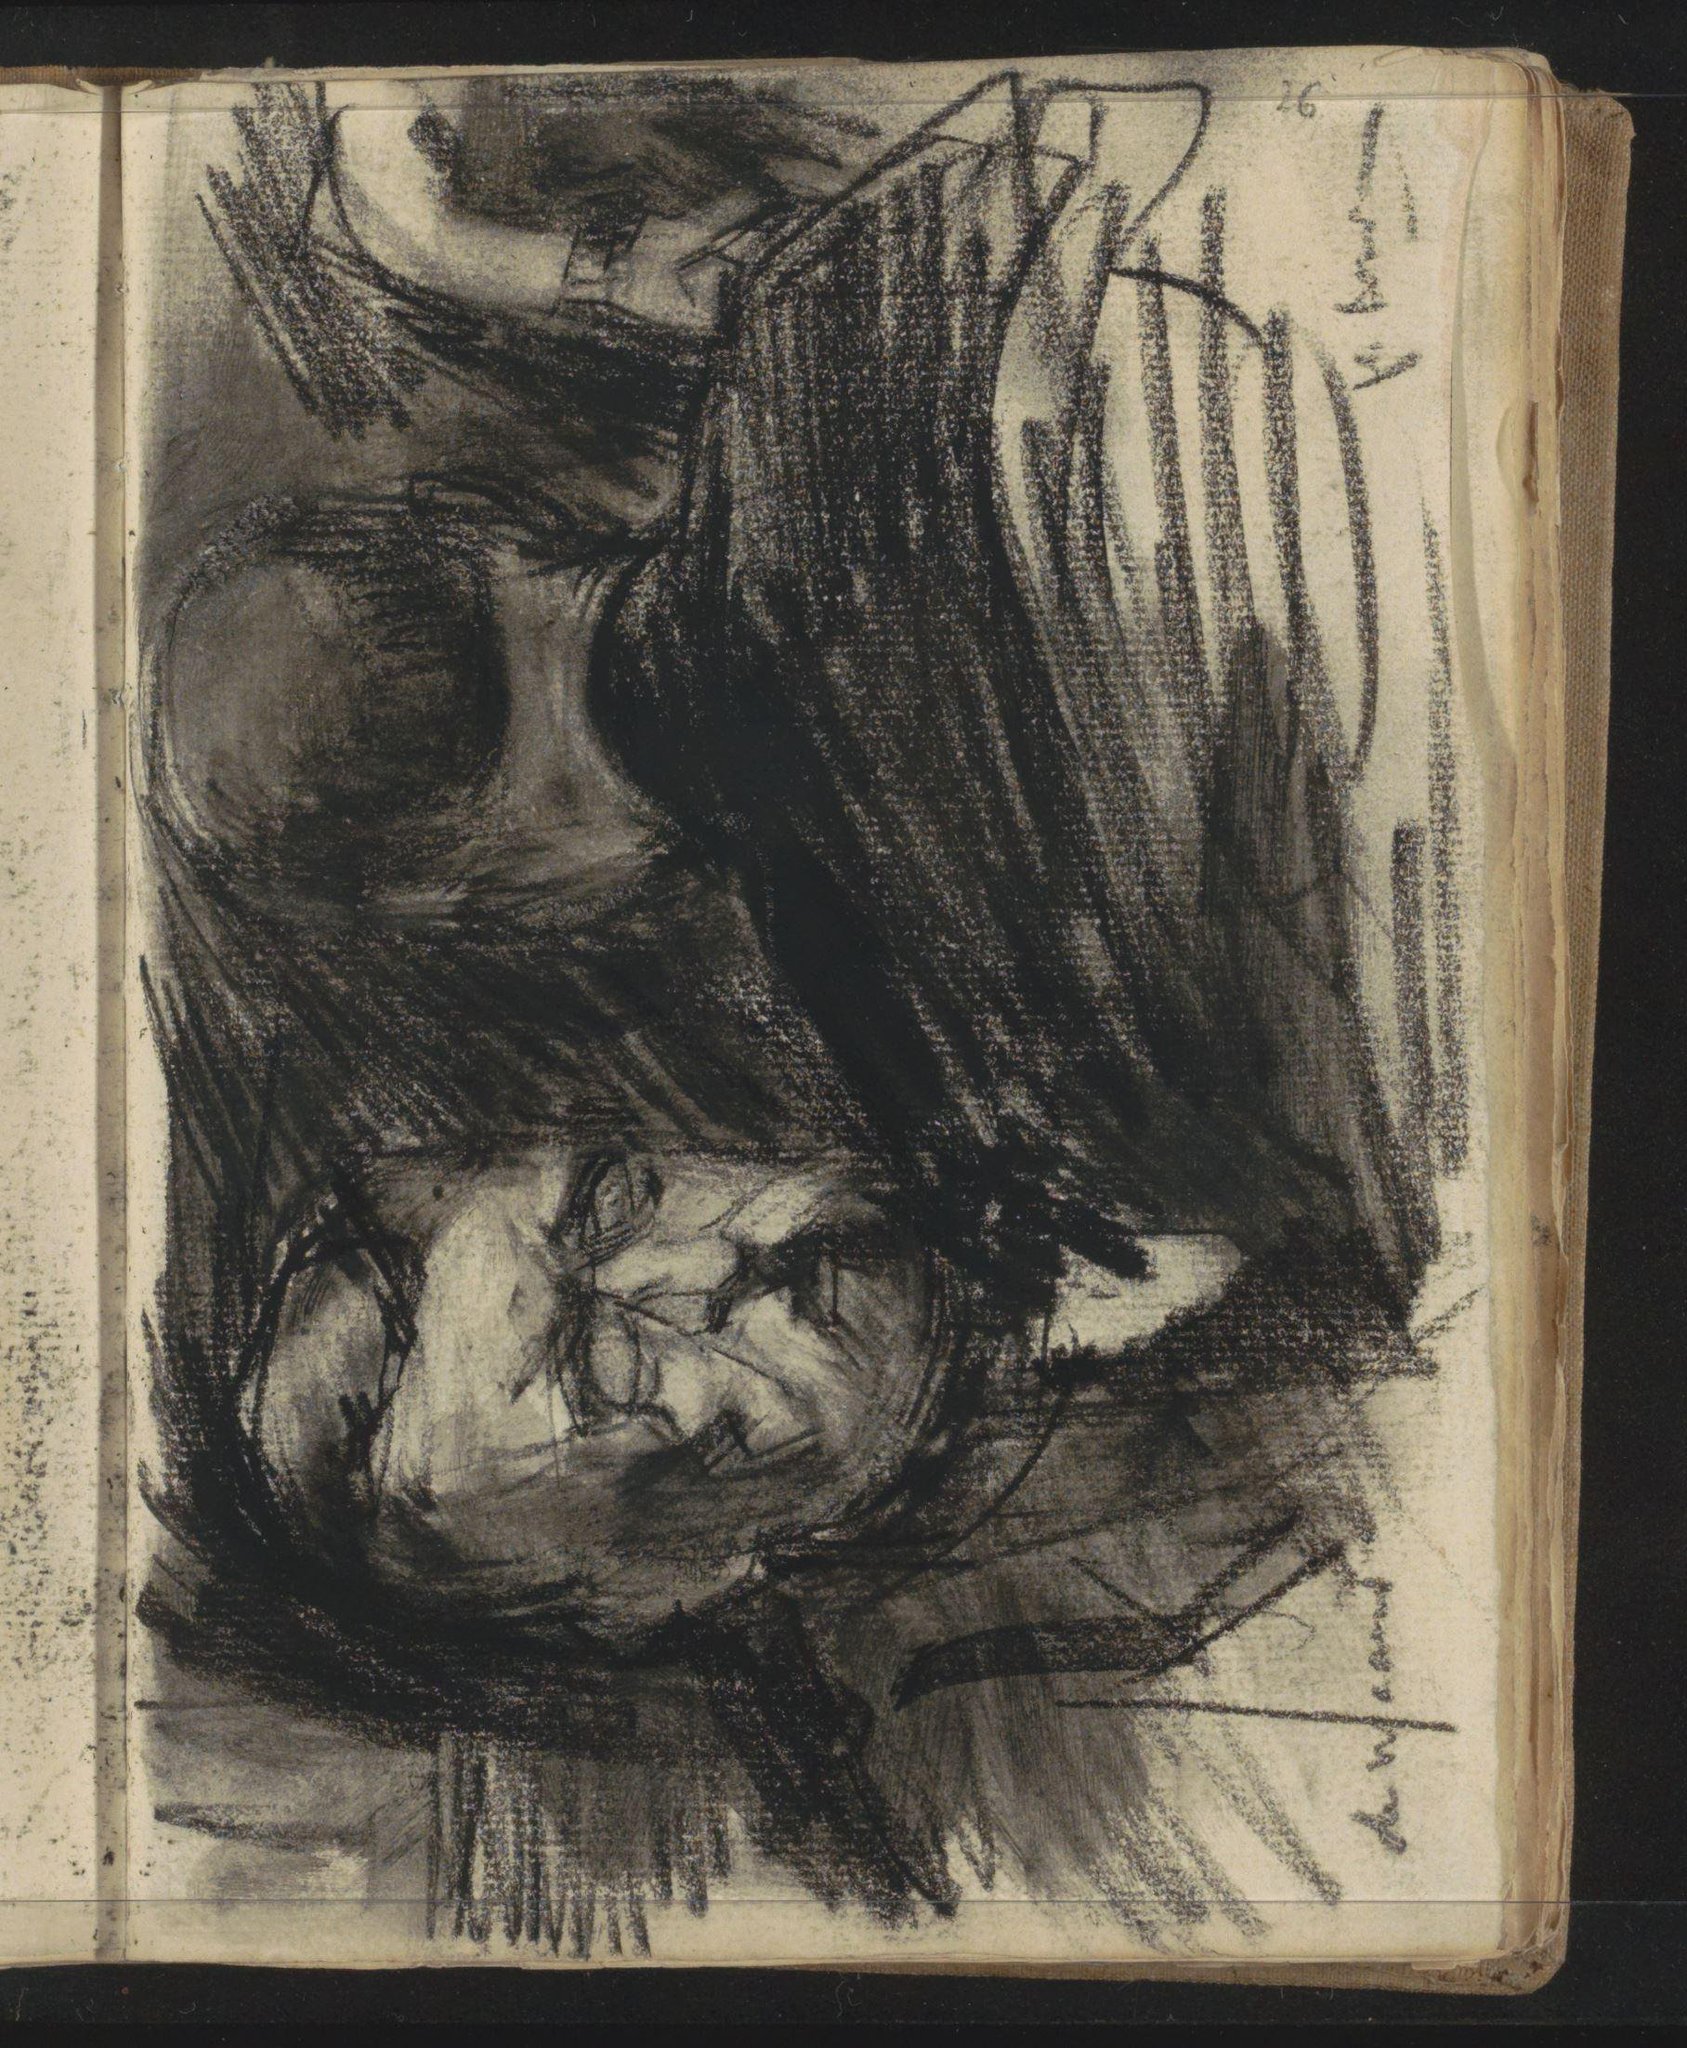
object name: sketchbook leaf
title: Drie mannen, onder wie mogelijk kunstenaar Jan de Waardt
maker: floris arntzenius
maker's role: draughtsman, print maker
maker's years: 1864-1925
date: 1883-1914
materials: chalk, paper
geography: the hague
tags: rotterdam, draughtsman, jan de waardt, adult man (+ three persons), portrait, self-portrait of artist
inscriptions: signature: ‘Fl. Arntzenius’, name: ‘de Waard’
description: Pagina 26 uit een schetsboek met 82 pagina's.